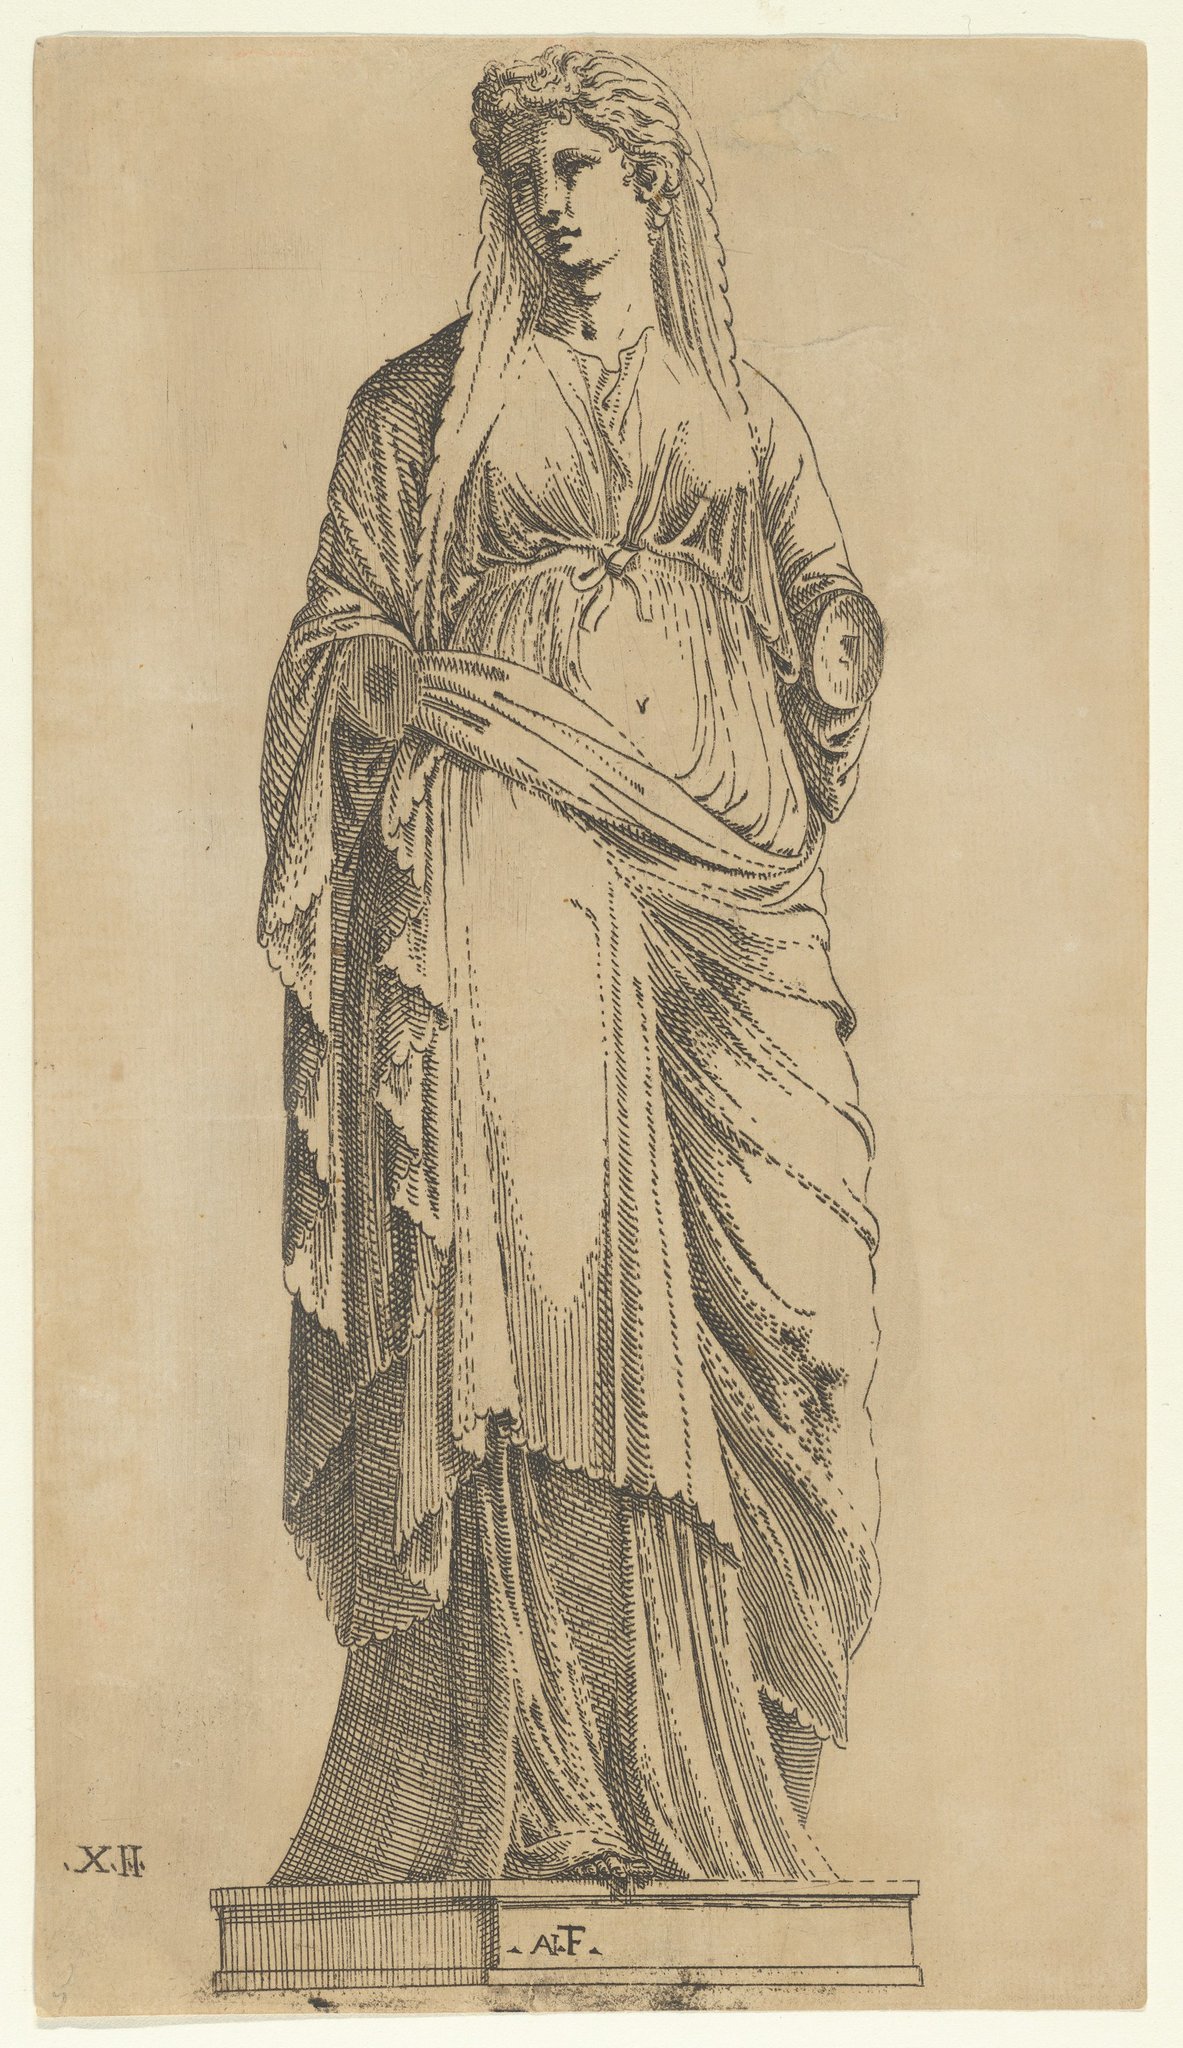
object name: print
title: Woman Full Face, Her Head Slightly to the Left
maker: antonio fantuzzi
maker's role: artist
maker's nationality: italian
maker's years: 1537-1545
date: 1543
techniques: etching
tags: faces,heads,women